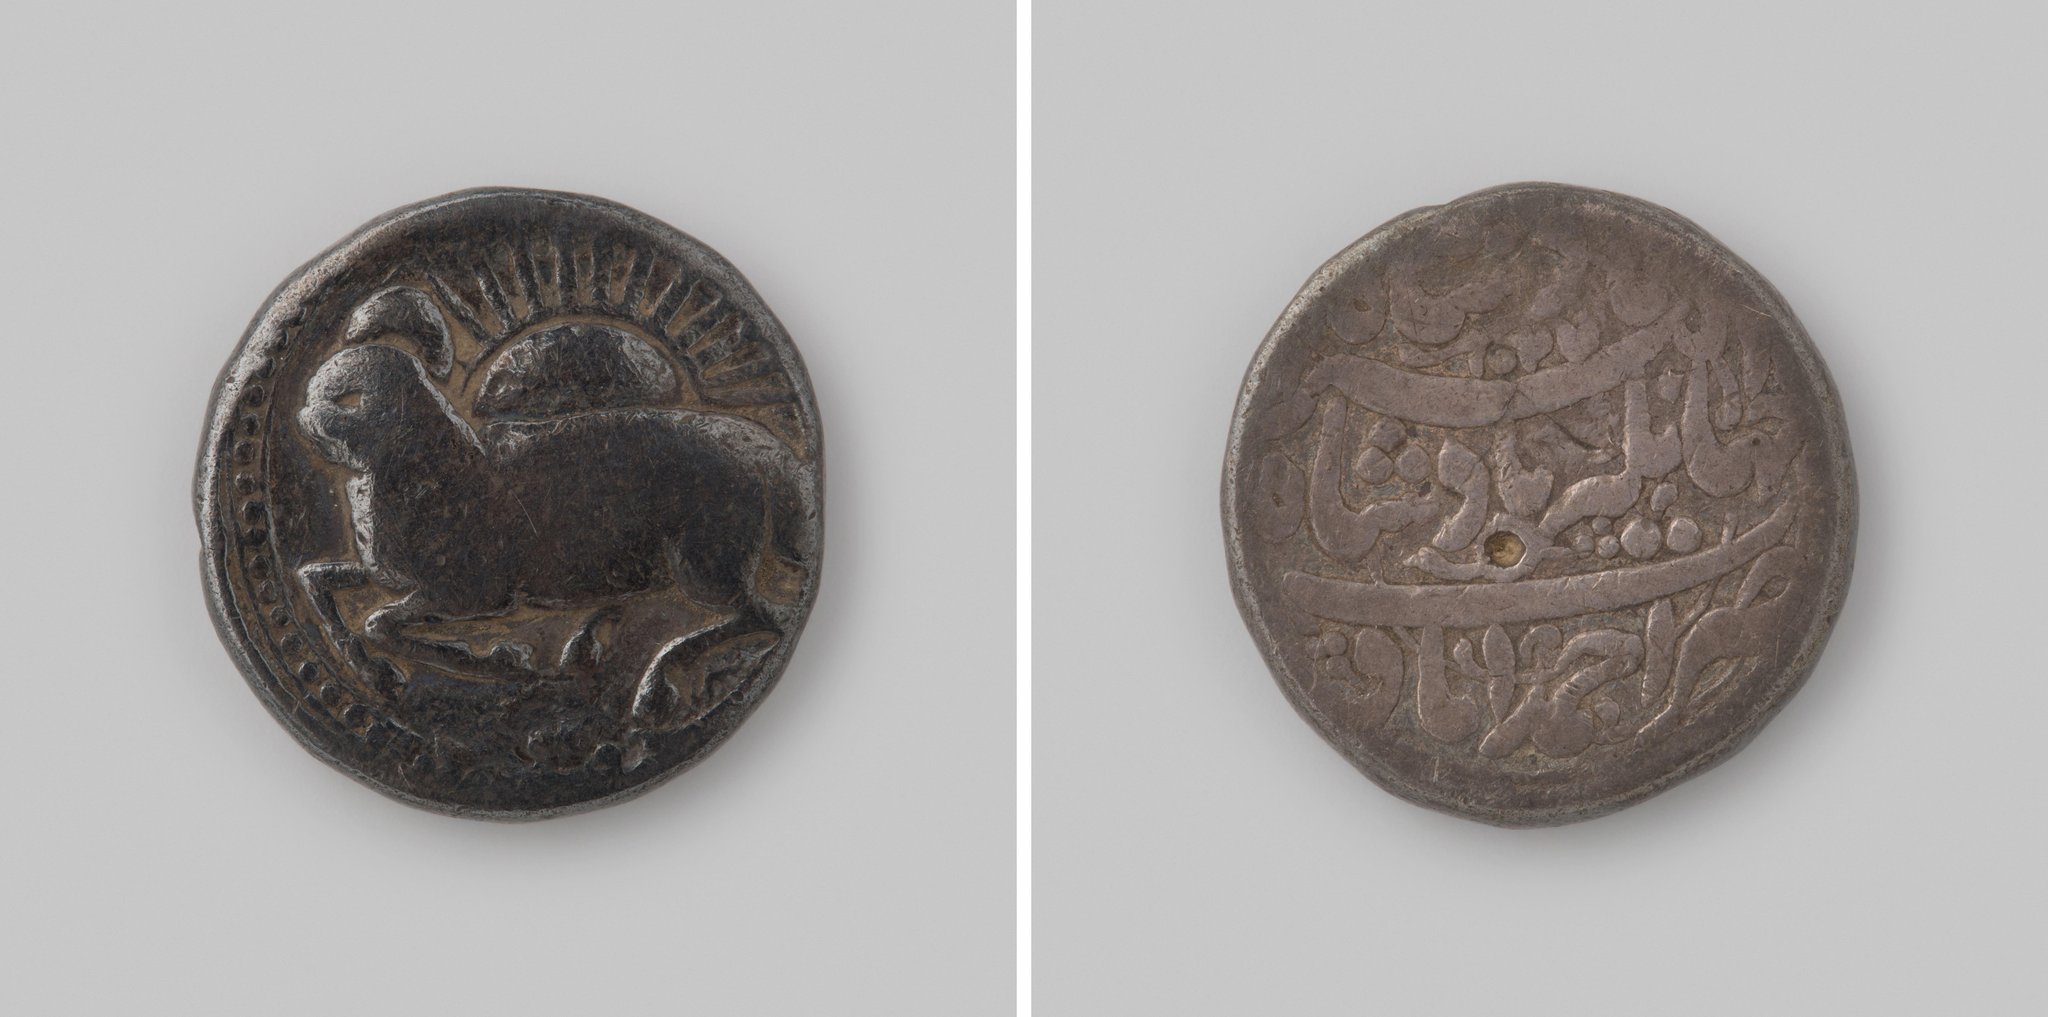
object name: coin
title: India, Jahangir, roepie, 1027 [=1618], geslagen te Ahmed-abad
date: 1618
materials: silver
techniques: striking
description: Zilveren munt. Voorzijde: ram naar links, waarachter opkomende stralende zon. Onder ram eenregelig opschrift in Arabische lettertekens. Keerzijde: in Arabische lettertekens in vier regels opschrift. Op eerste regel jaartal: 1027, op onderste regel aanduiding muntplaats: Ahmed-abad.